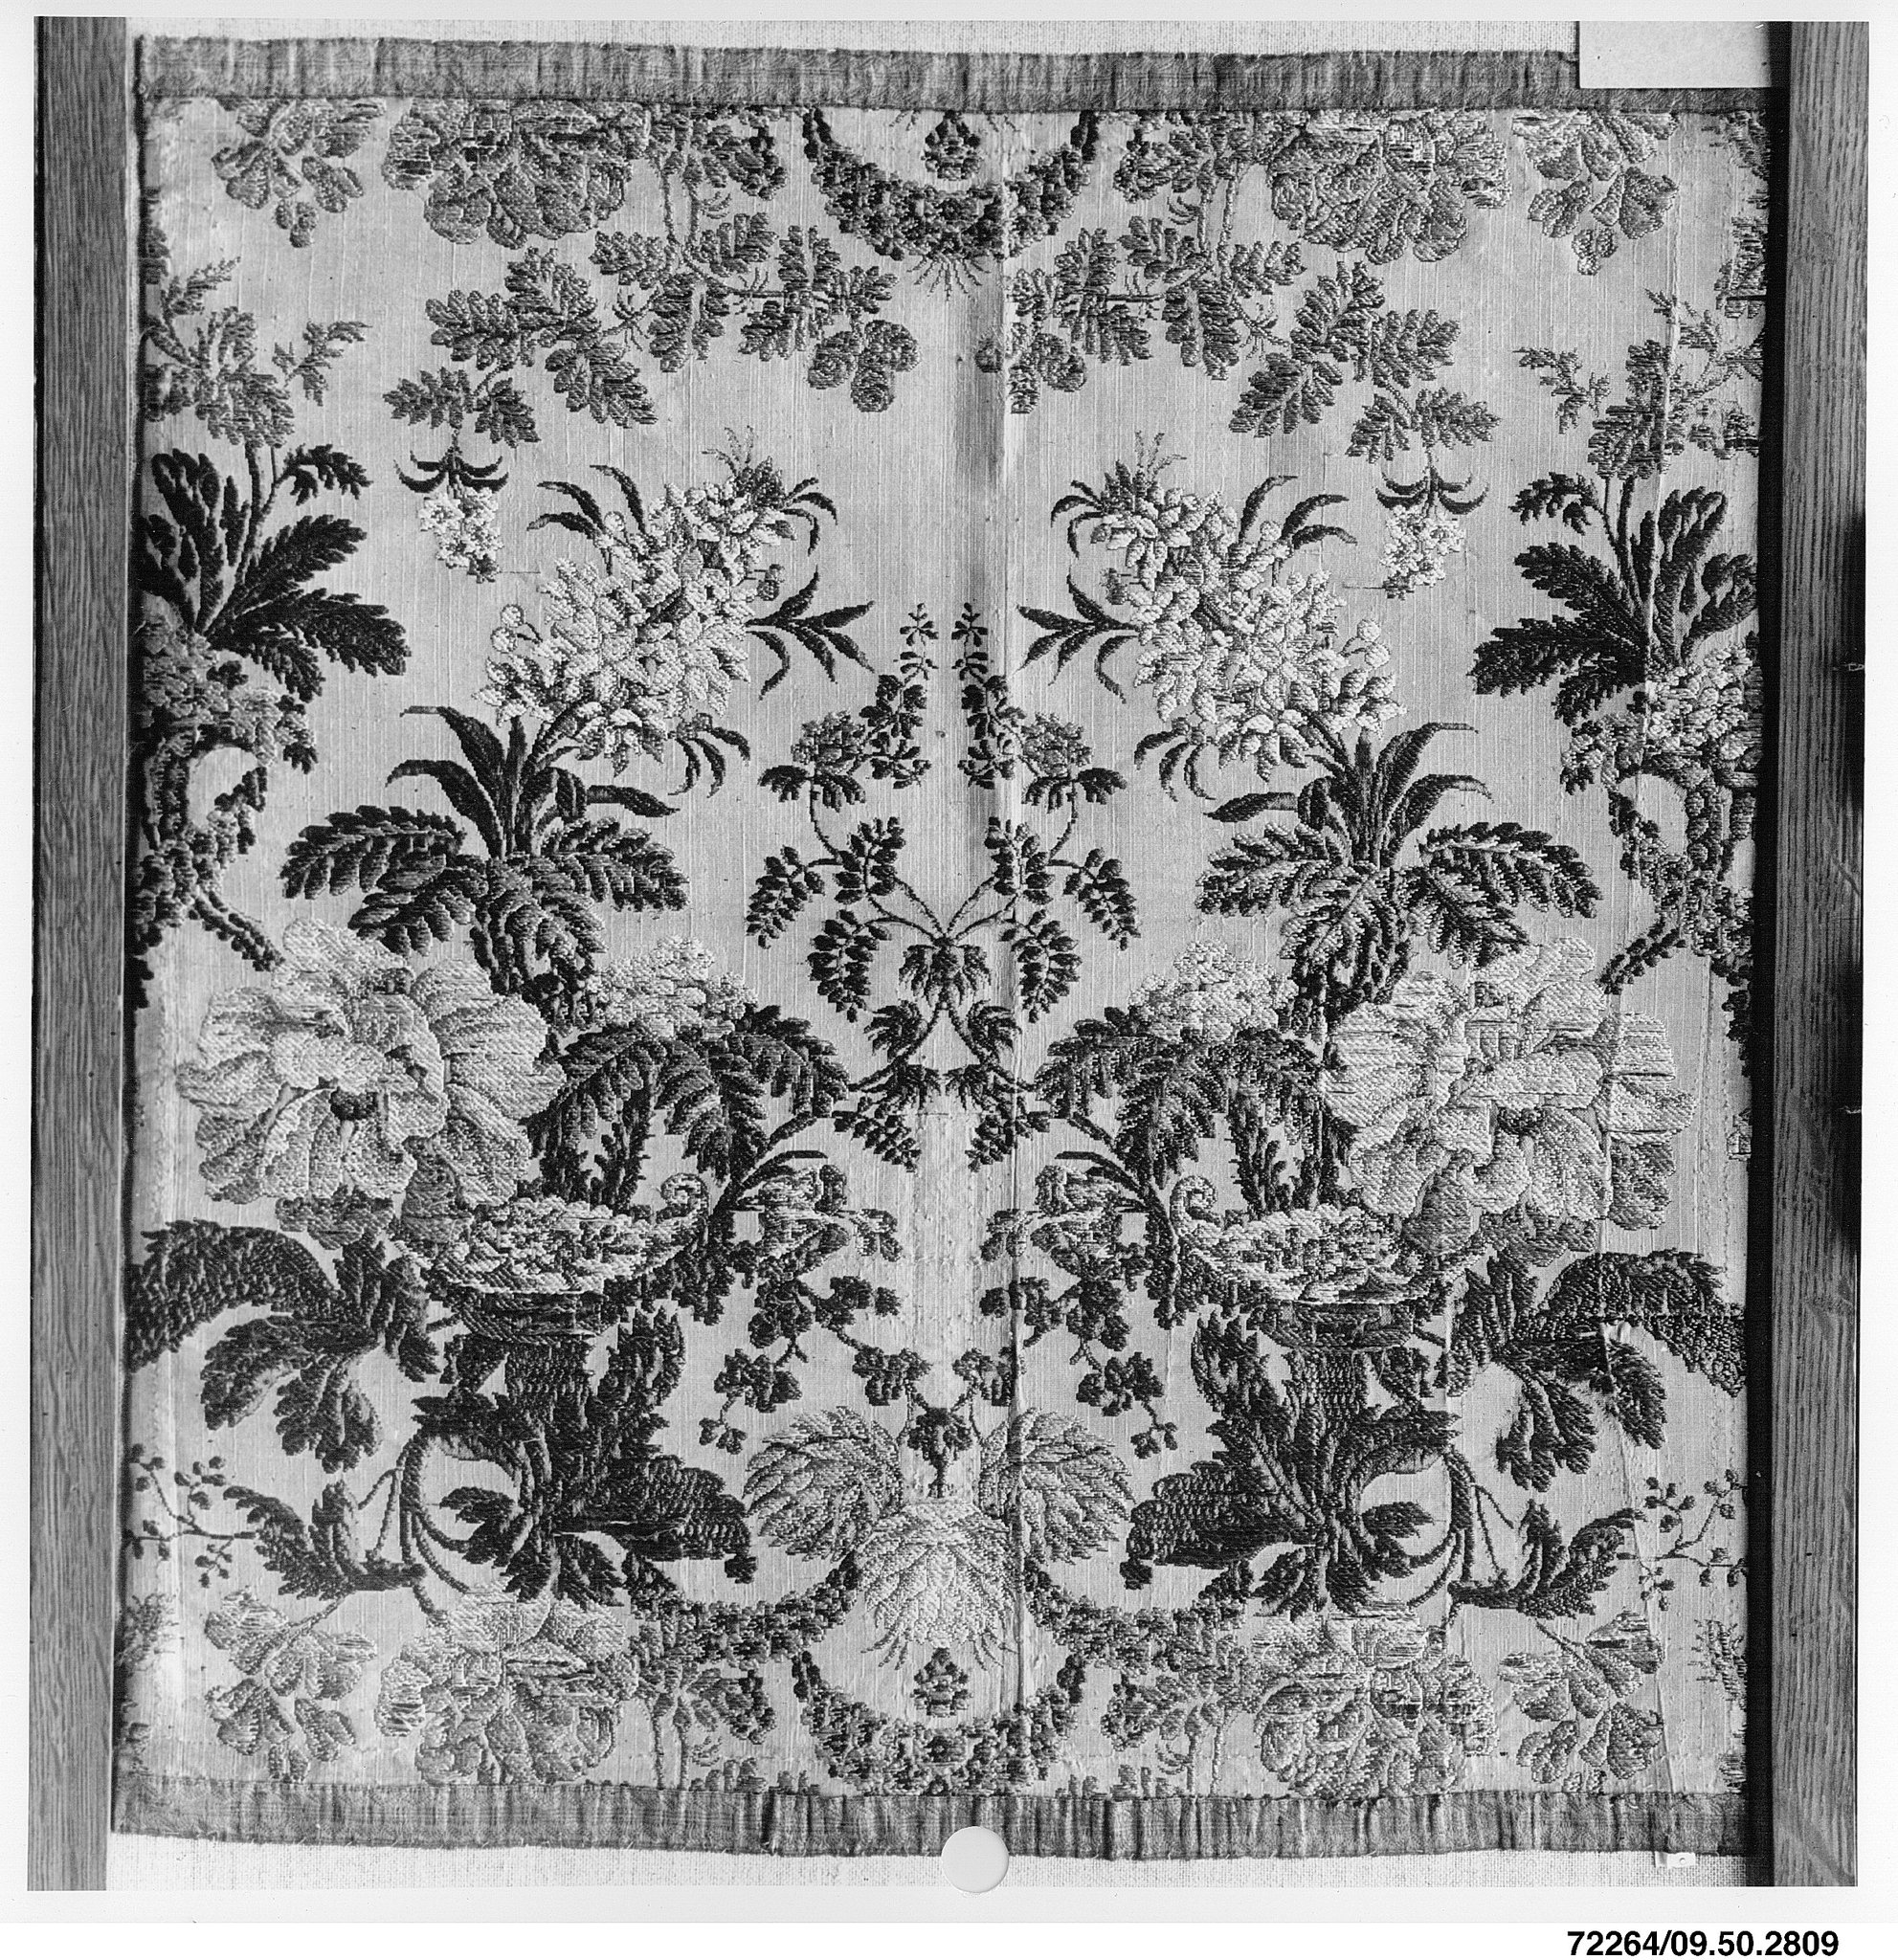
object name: piece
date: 1730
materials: silk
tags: flowers,leaves